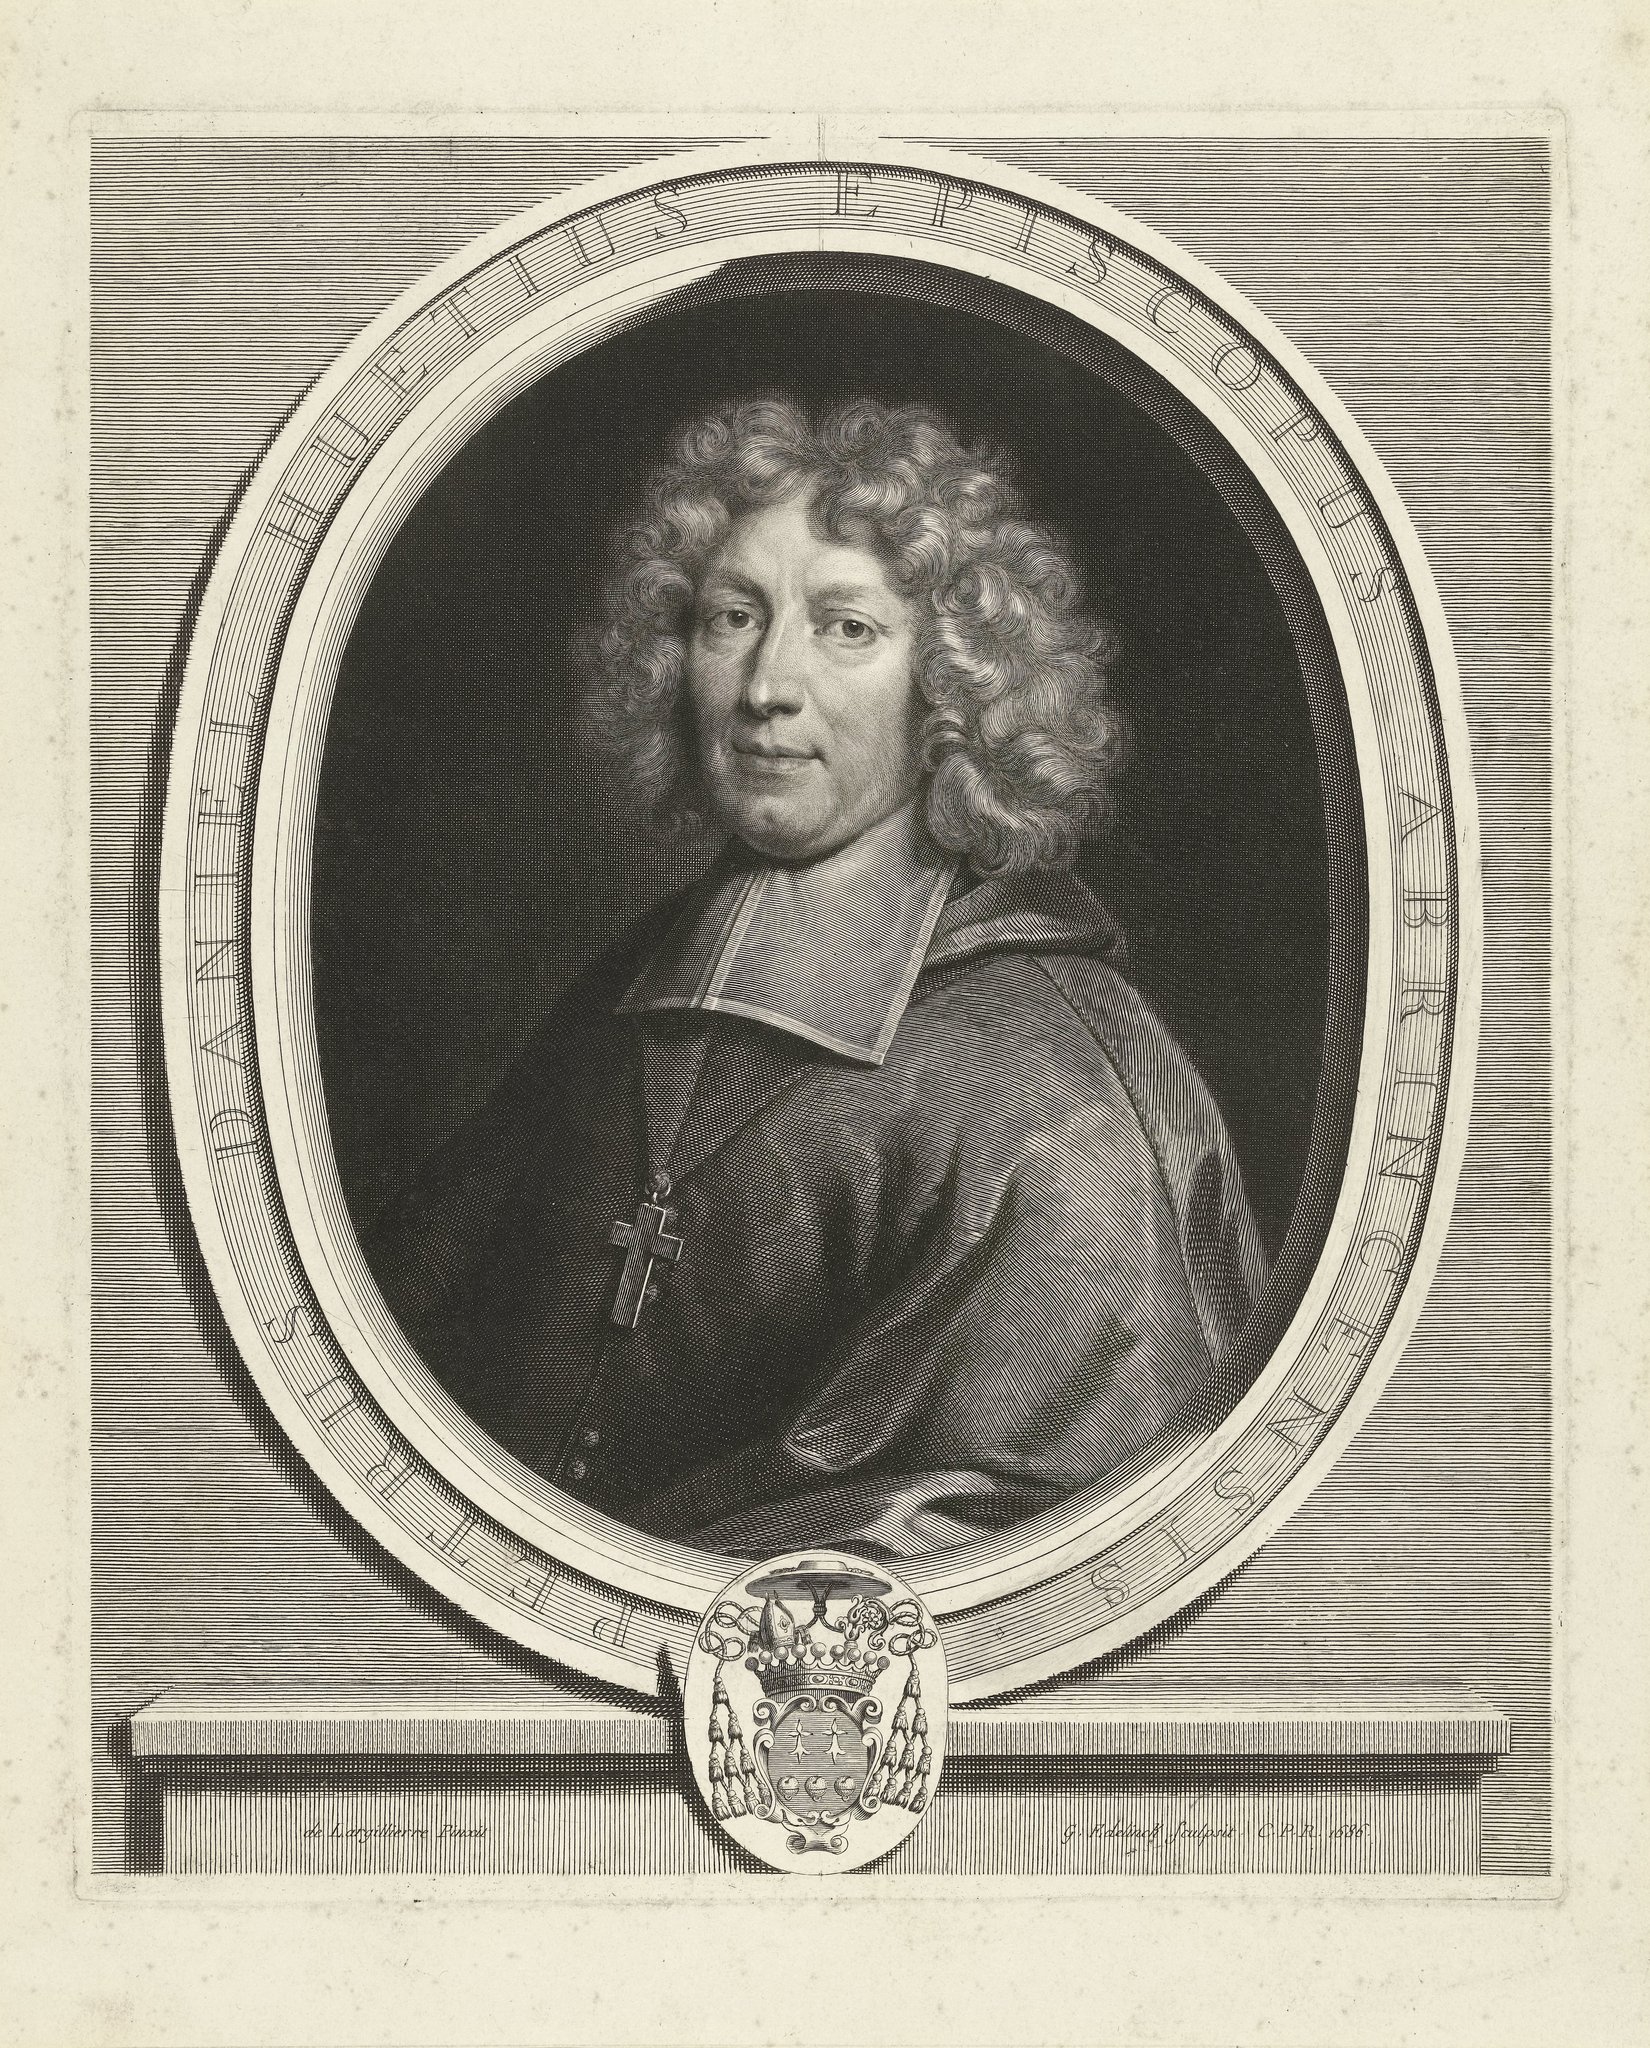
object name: print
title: Portret van Pierre-Daniel Huet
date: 1686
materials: paper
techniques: engraving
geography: france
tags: paris, pierre daniel huet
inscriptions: collector's mark: Lugt 240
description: Portret van de Franse filosoof en bisschop Pierre-Daniel Huet (1630-1721), afgebeeld in ovale omlijsting met wapen.